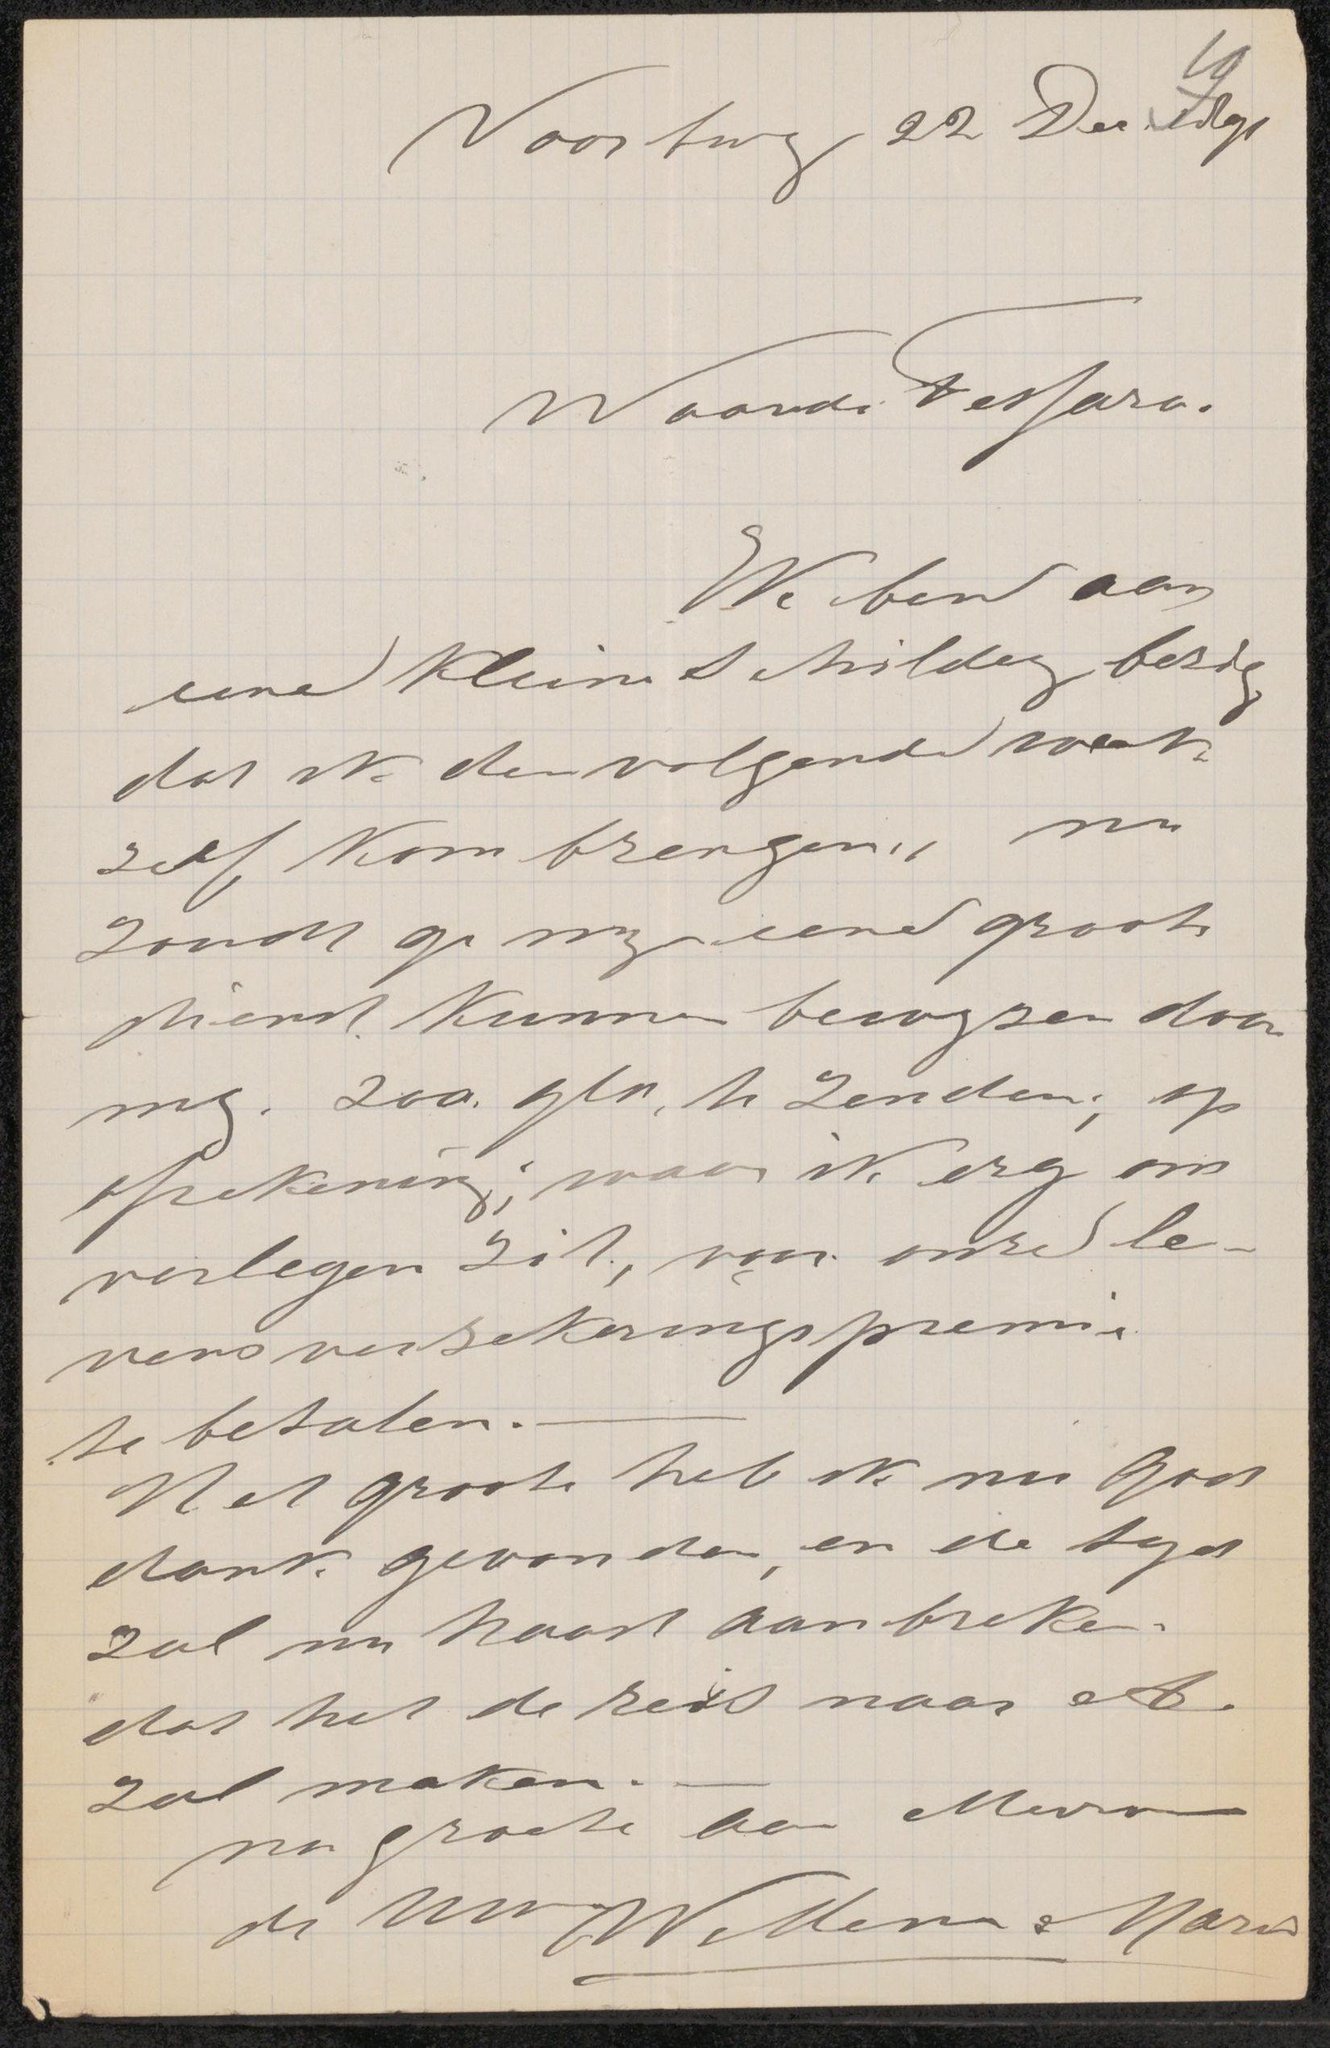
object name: letter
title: Brief aan Filippo Tessaro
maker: willem maris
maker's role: draughtsman, painter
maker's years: 1844-1910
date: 1891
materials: ink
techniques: pen, writing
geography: voorburg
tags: art trade, art shop, painting (including book-illumination, miniature-painting), money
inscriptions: collector's mark: Lugt 2228, collector's mark: Lugt 2233